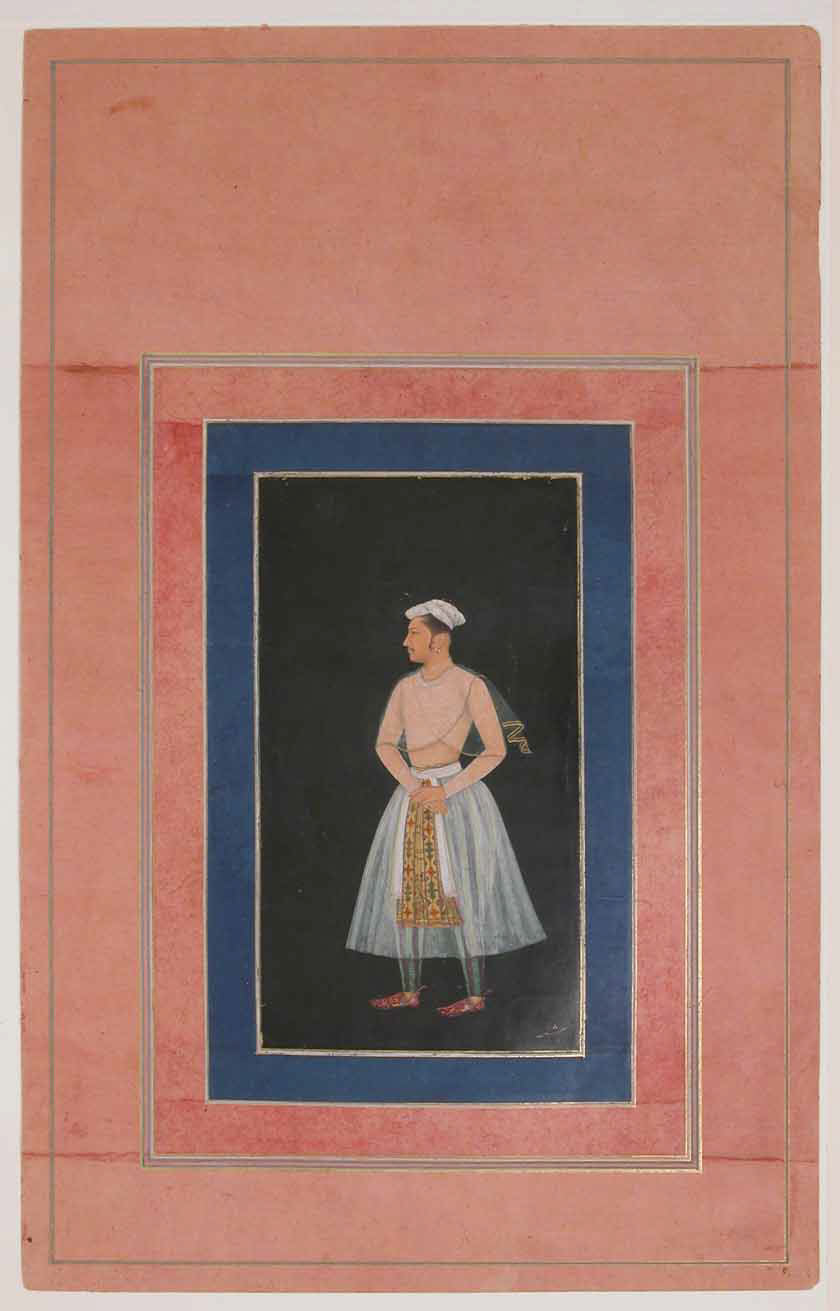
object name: illustrated album leaf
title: "Portrait of a Prince (Shah Jahan ?)", Folio from the Davis Album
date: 1634-1666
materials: gold, ink, paper, watercolor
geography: india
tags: princes,profiles